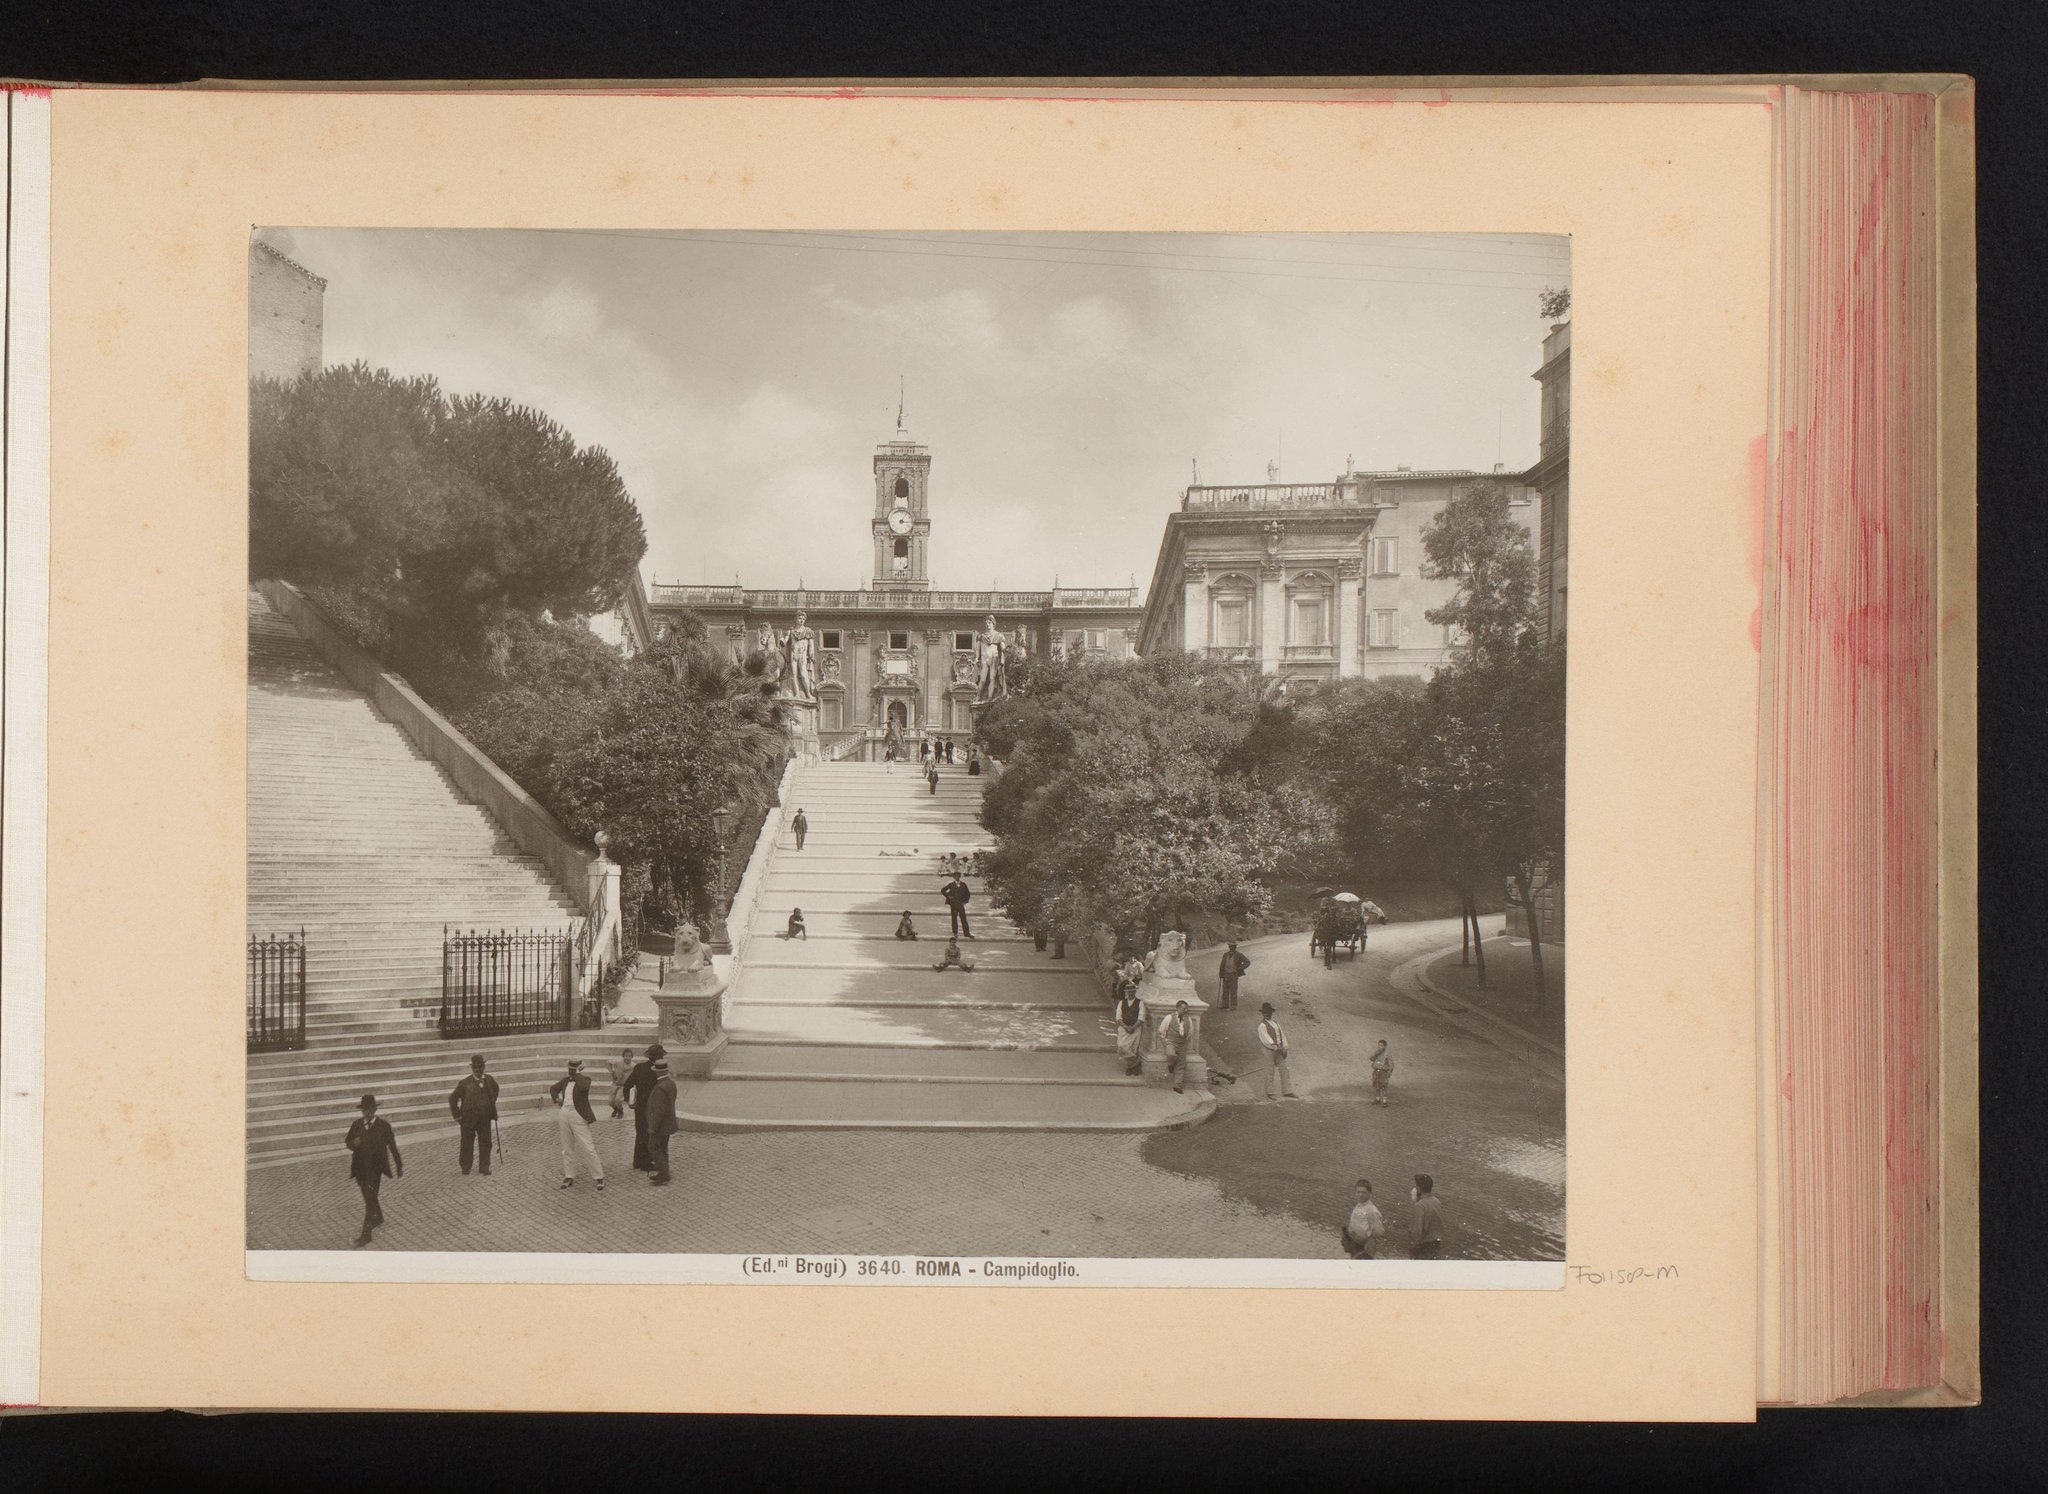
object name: photograph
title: Roma - Campidoglio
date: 1875-1907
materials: photographic support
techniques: gelatin silver print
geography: rome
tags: staircase, façade (of house or building)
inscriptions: number: ‘3640’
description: Onderdeel van Fotoalbum met opnames van bezienswaardigheden en kunstwerken in Italië.